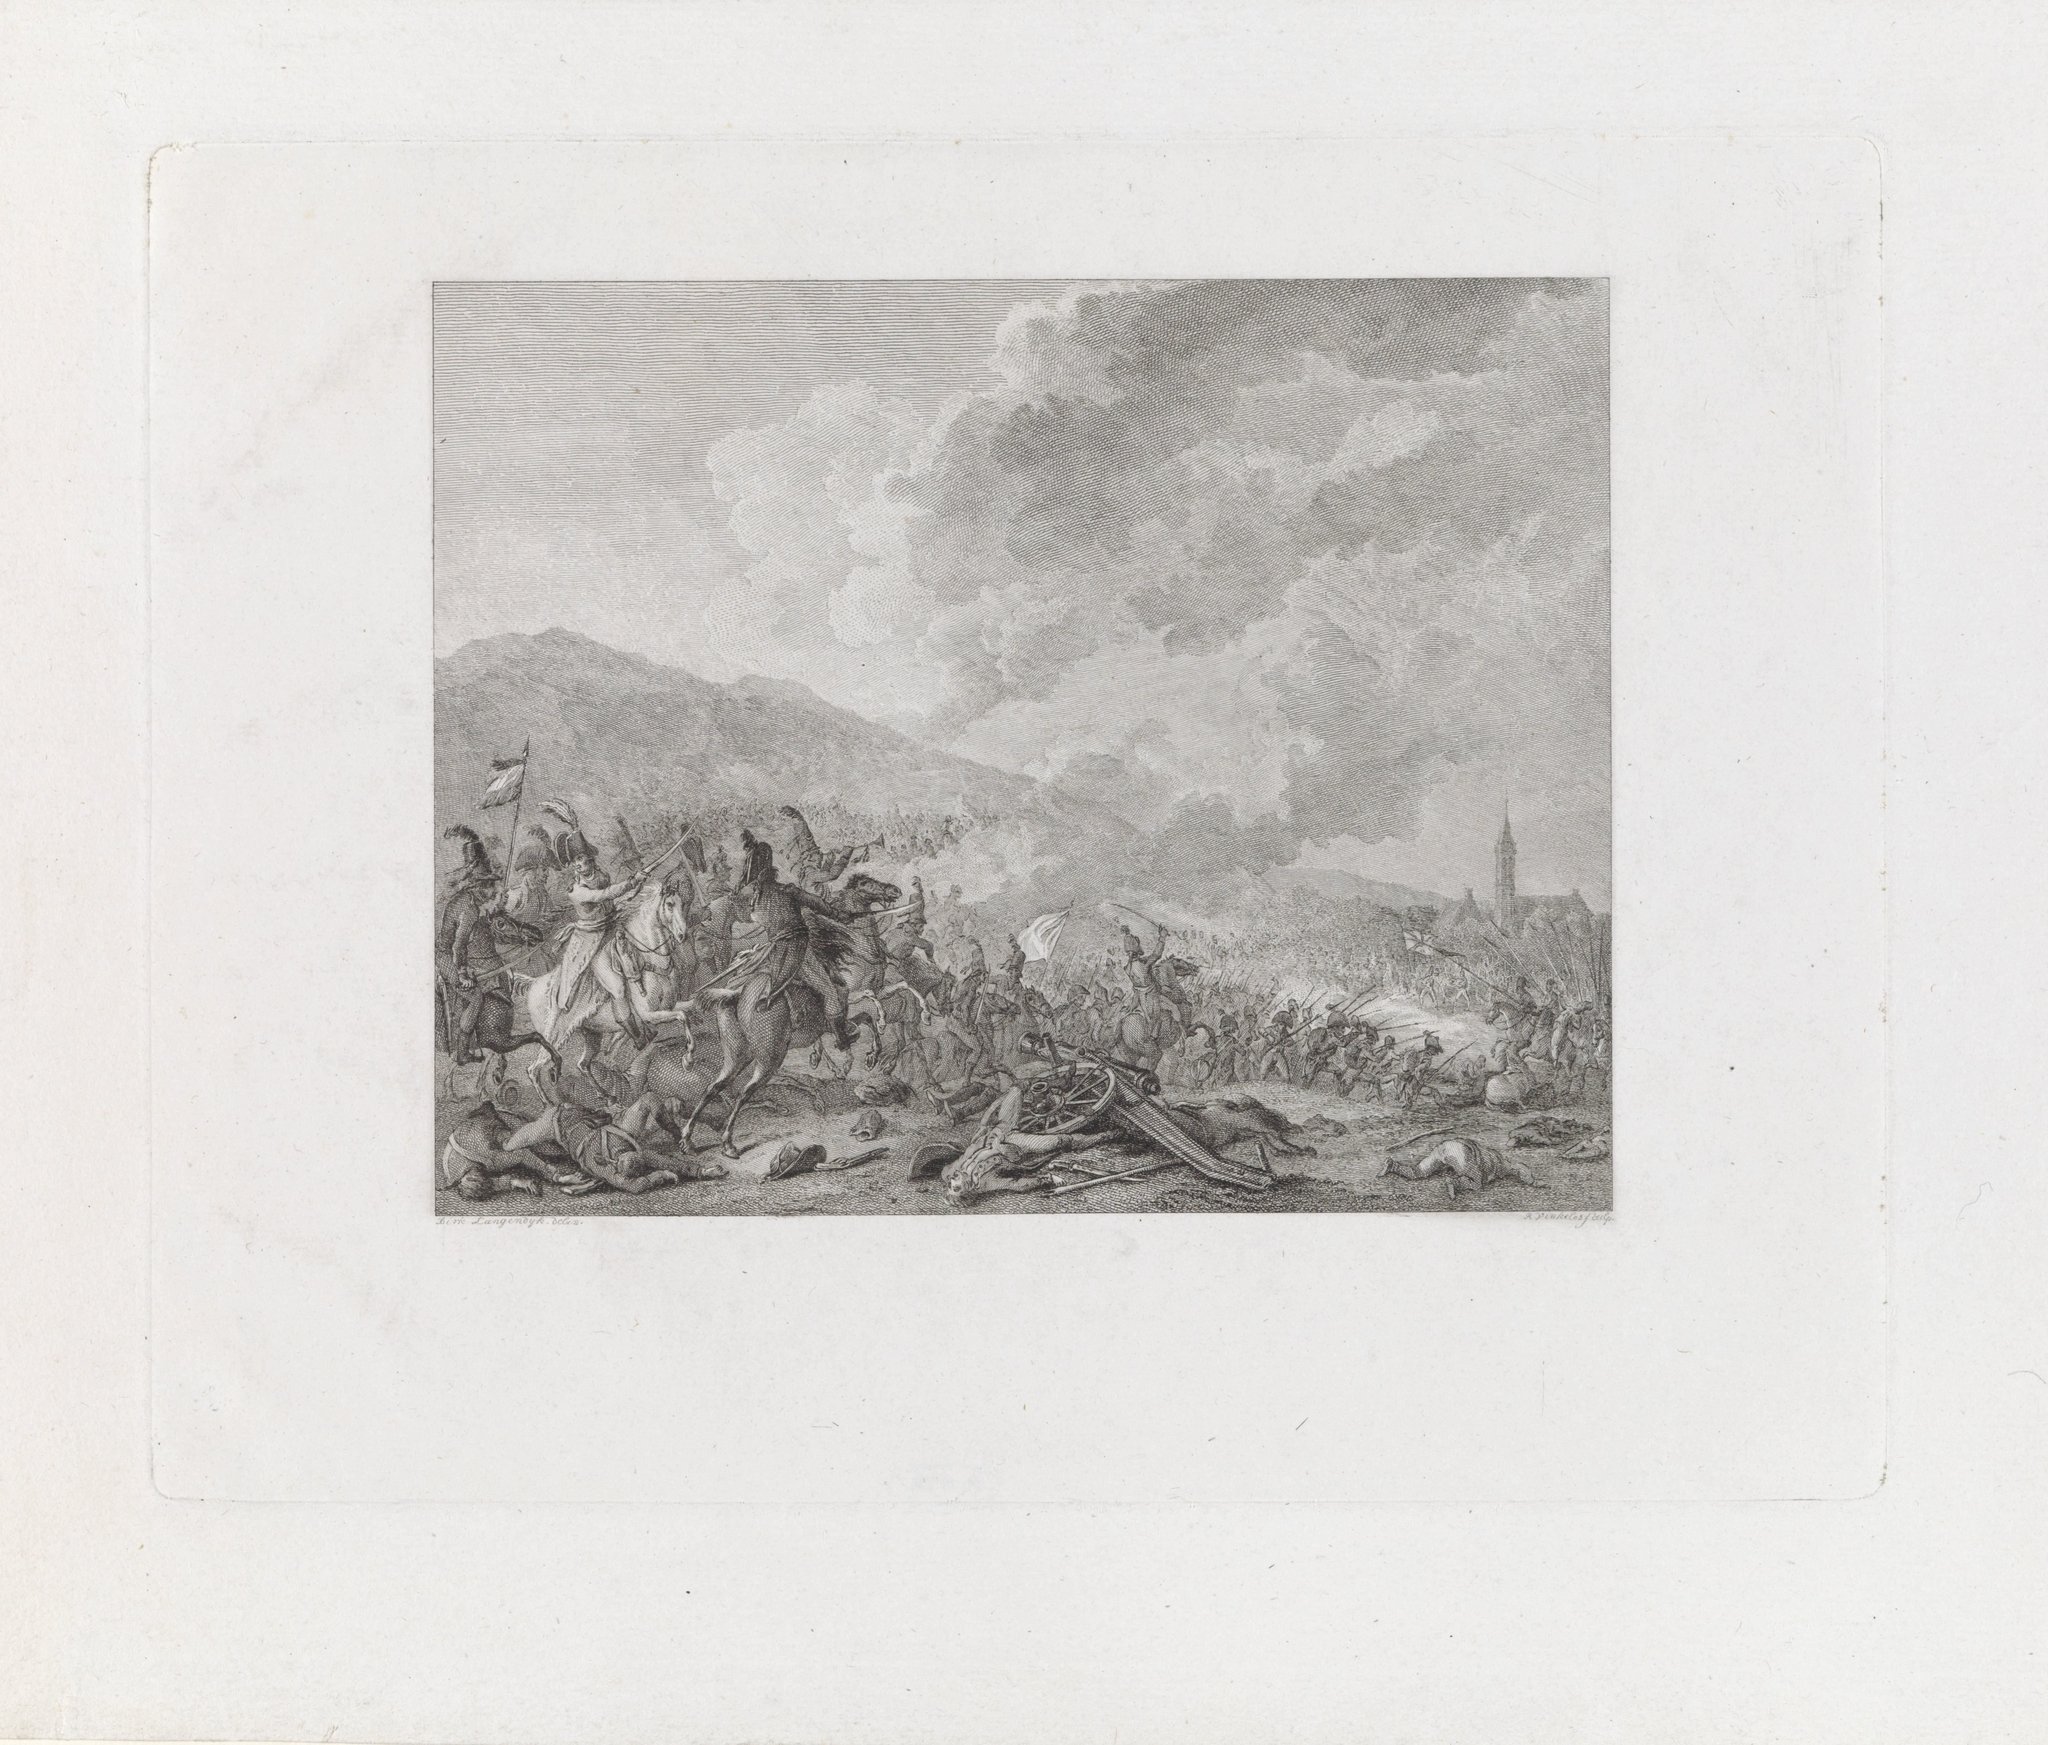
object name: print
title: Slag bij Castricum, 1799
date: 1800-1802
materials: paper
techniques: engraving, etching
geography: netherlands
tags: battle (+ land forces)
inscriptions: collector's mark: Lugt 2228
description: Gebruikt als illustratie in: L.C. Vonk. Geschiedenis der landing van het Engelsch-Russisch leger in Noord-Holland; alsmede der krijgsbedrijven en politieke gebeurtenissen, zoo aldaar, als in Vriesland en Gelderland, in den jare 1799. Haarlem: François Bohn, 2 dln, 1801-1802.